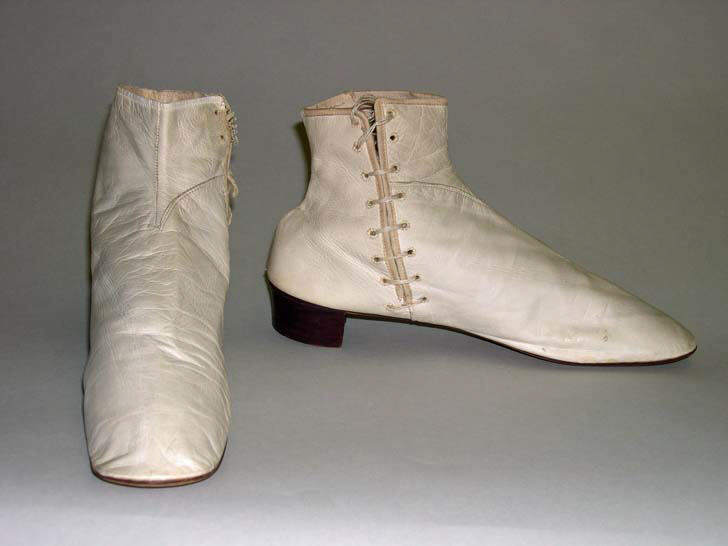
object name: wedding shoe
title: Wedding shoes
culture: american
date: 1855-1865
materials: leather